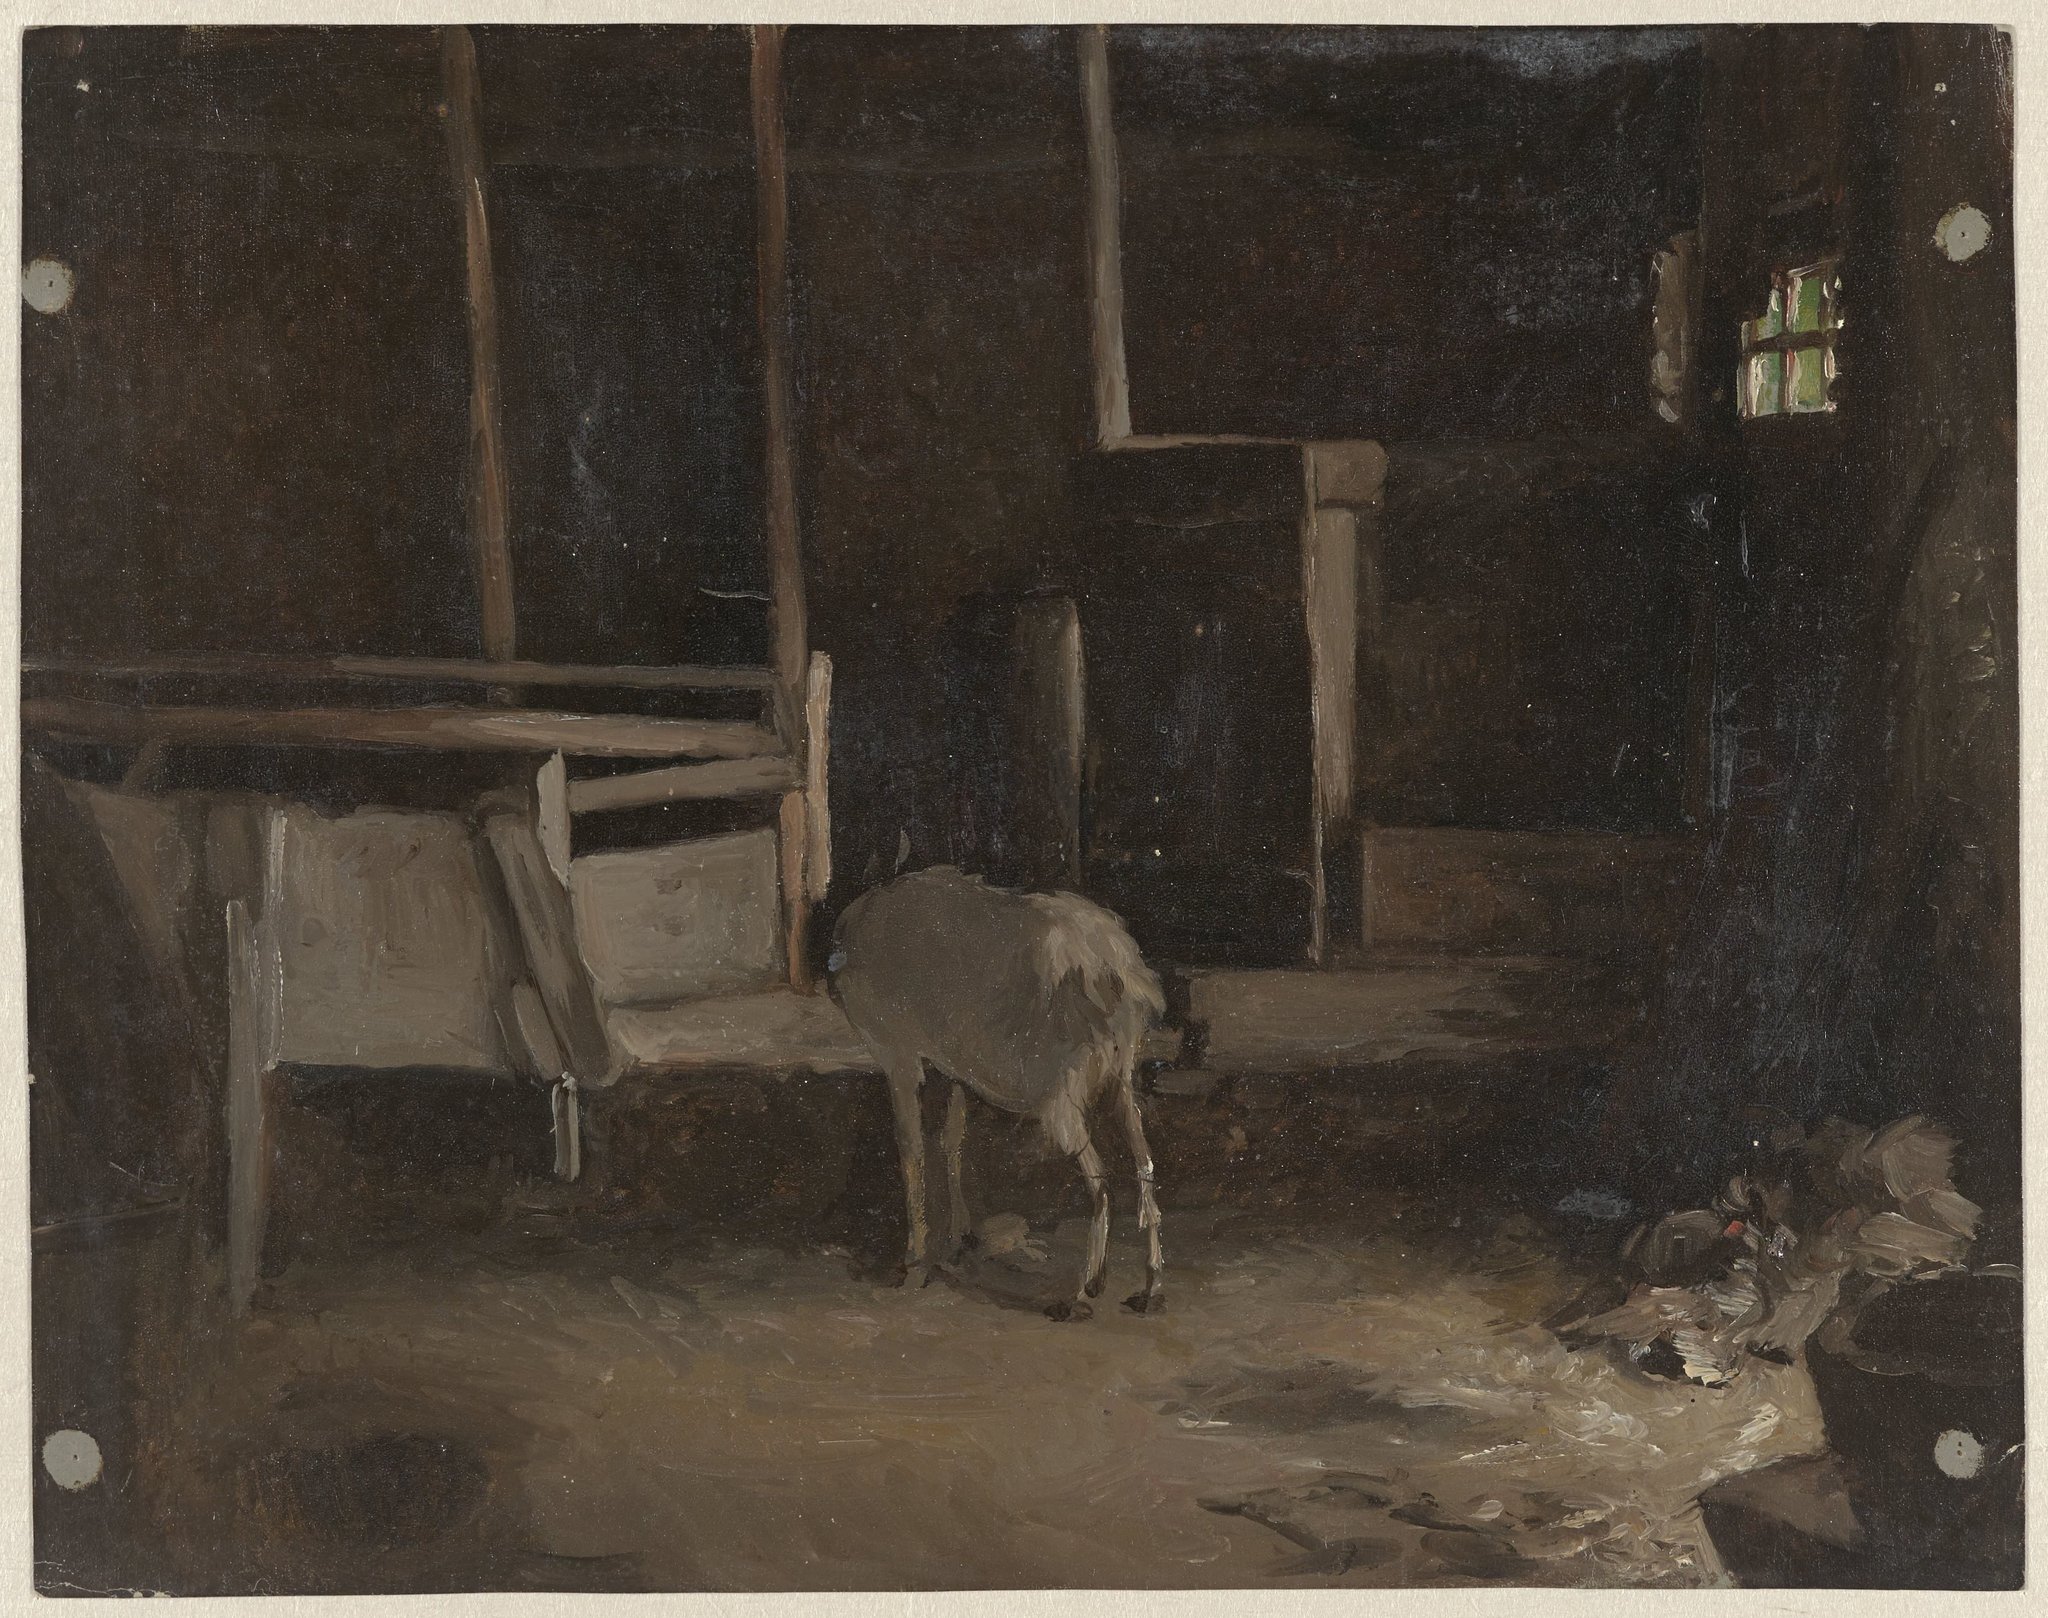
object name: drawing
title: Geitje in een stal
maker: guillaume anne van der brugghen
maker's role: draughtsman, print maker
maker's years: 1812-1891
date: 1821-1891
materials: oil, paper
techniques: brush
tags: stall, stable, goat